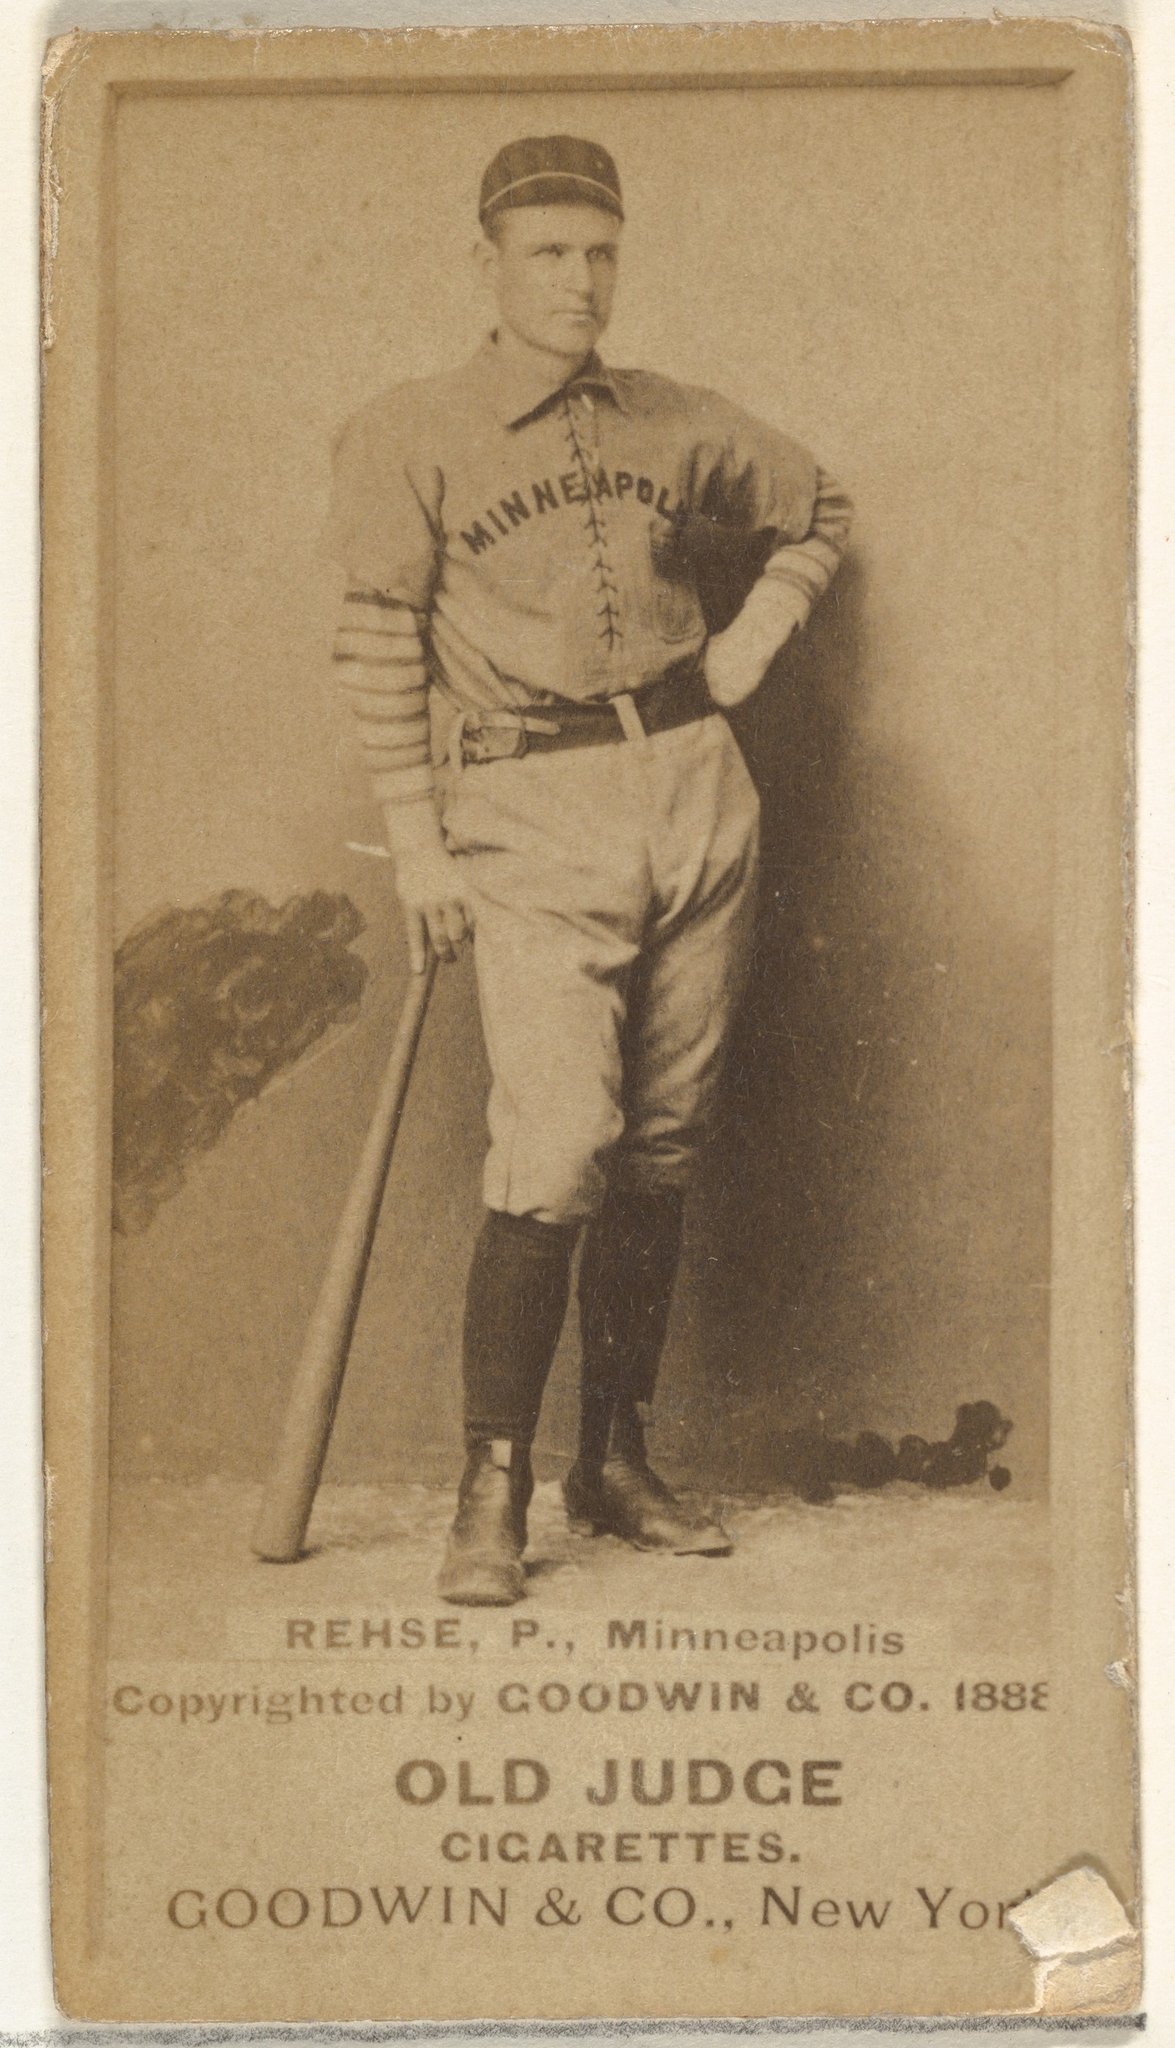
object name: baseball card, photograph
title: Rehse, Pitcher, Minneapolis, from the Old Judge series (N172) for Old Judge Cigarettes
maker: goodwin & company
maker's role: publisher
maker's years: 1850-1950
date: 1888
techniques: albumen silver print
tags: men,portraits,baseball,athletes